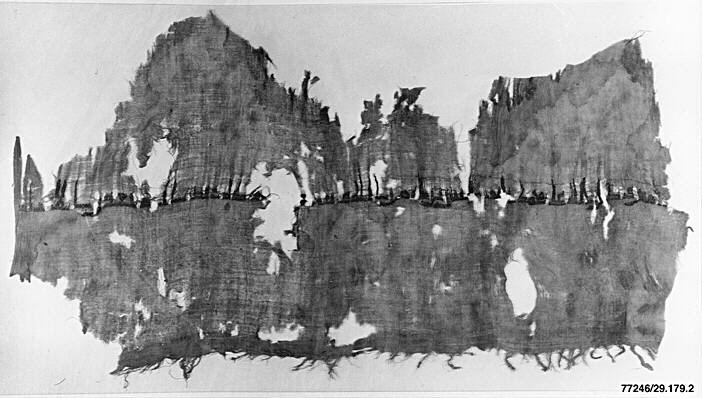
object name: textile fragment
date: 901-1000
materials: linen, silk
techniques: weave, tapestry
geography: egypt